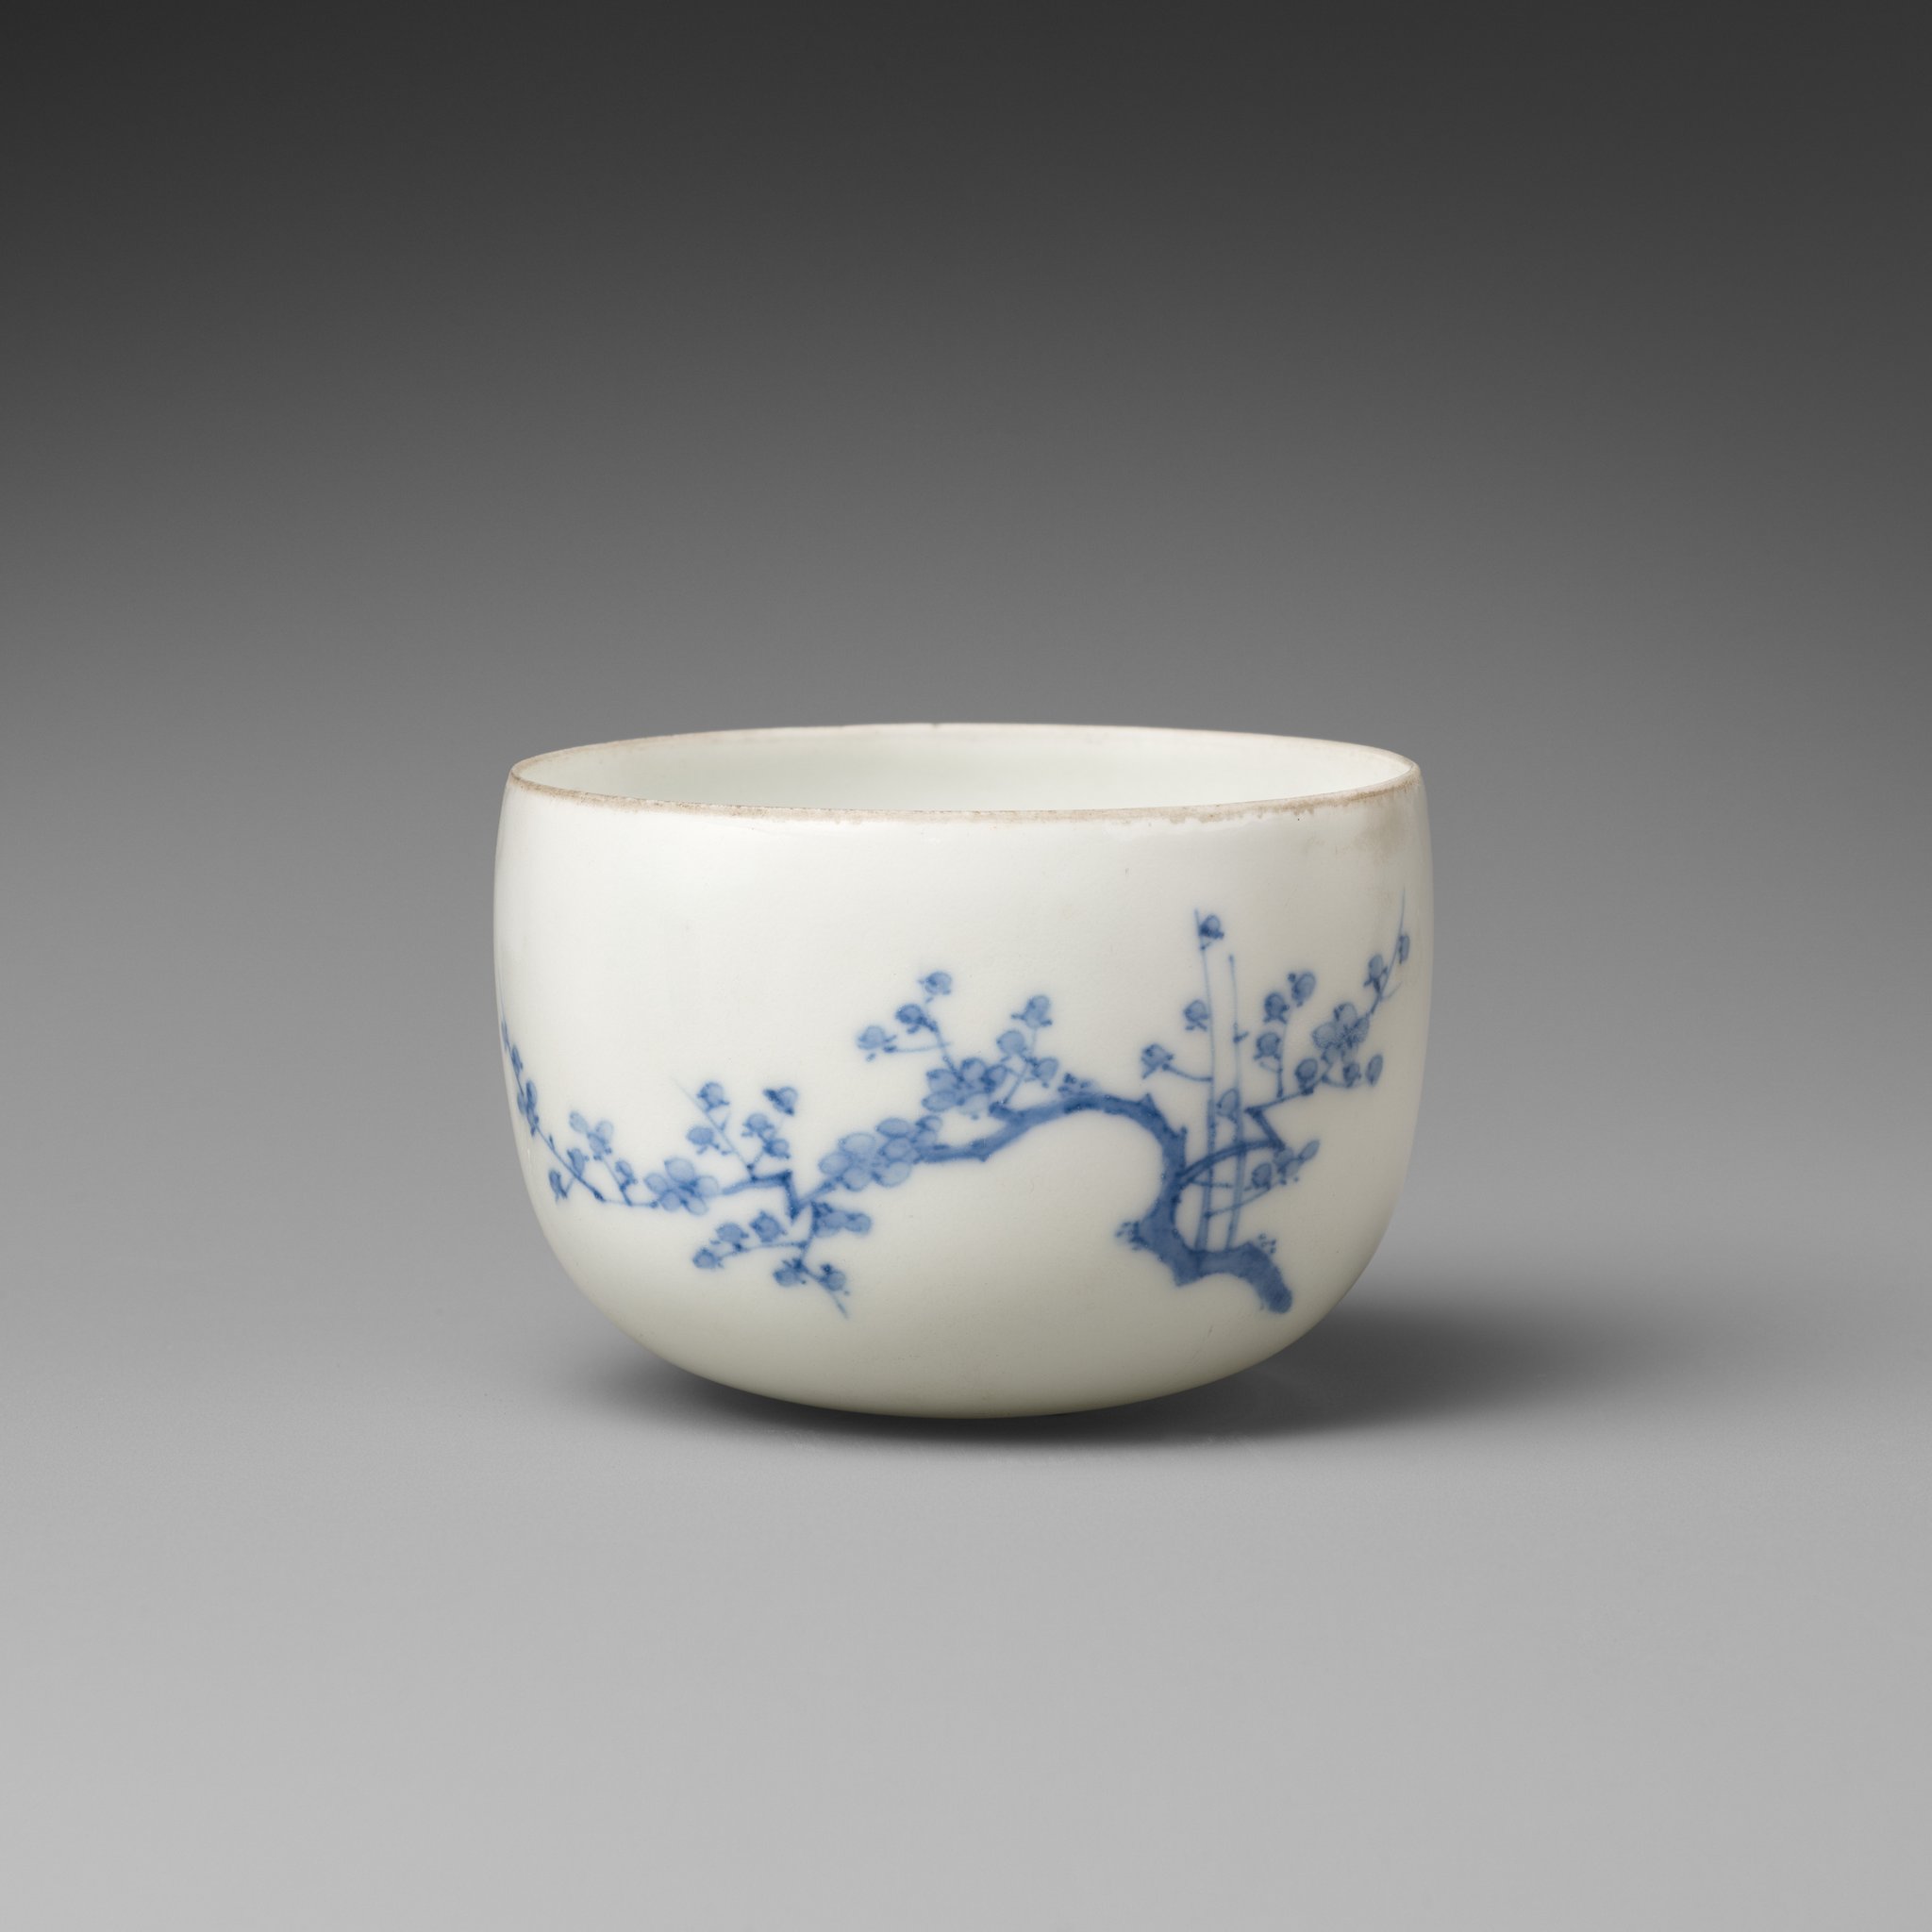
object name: cup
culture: japanese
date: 1780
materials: porcelain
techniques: underglaze